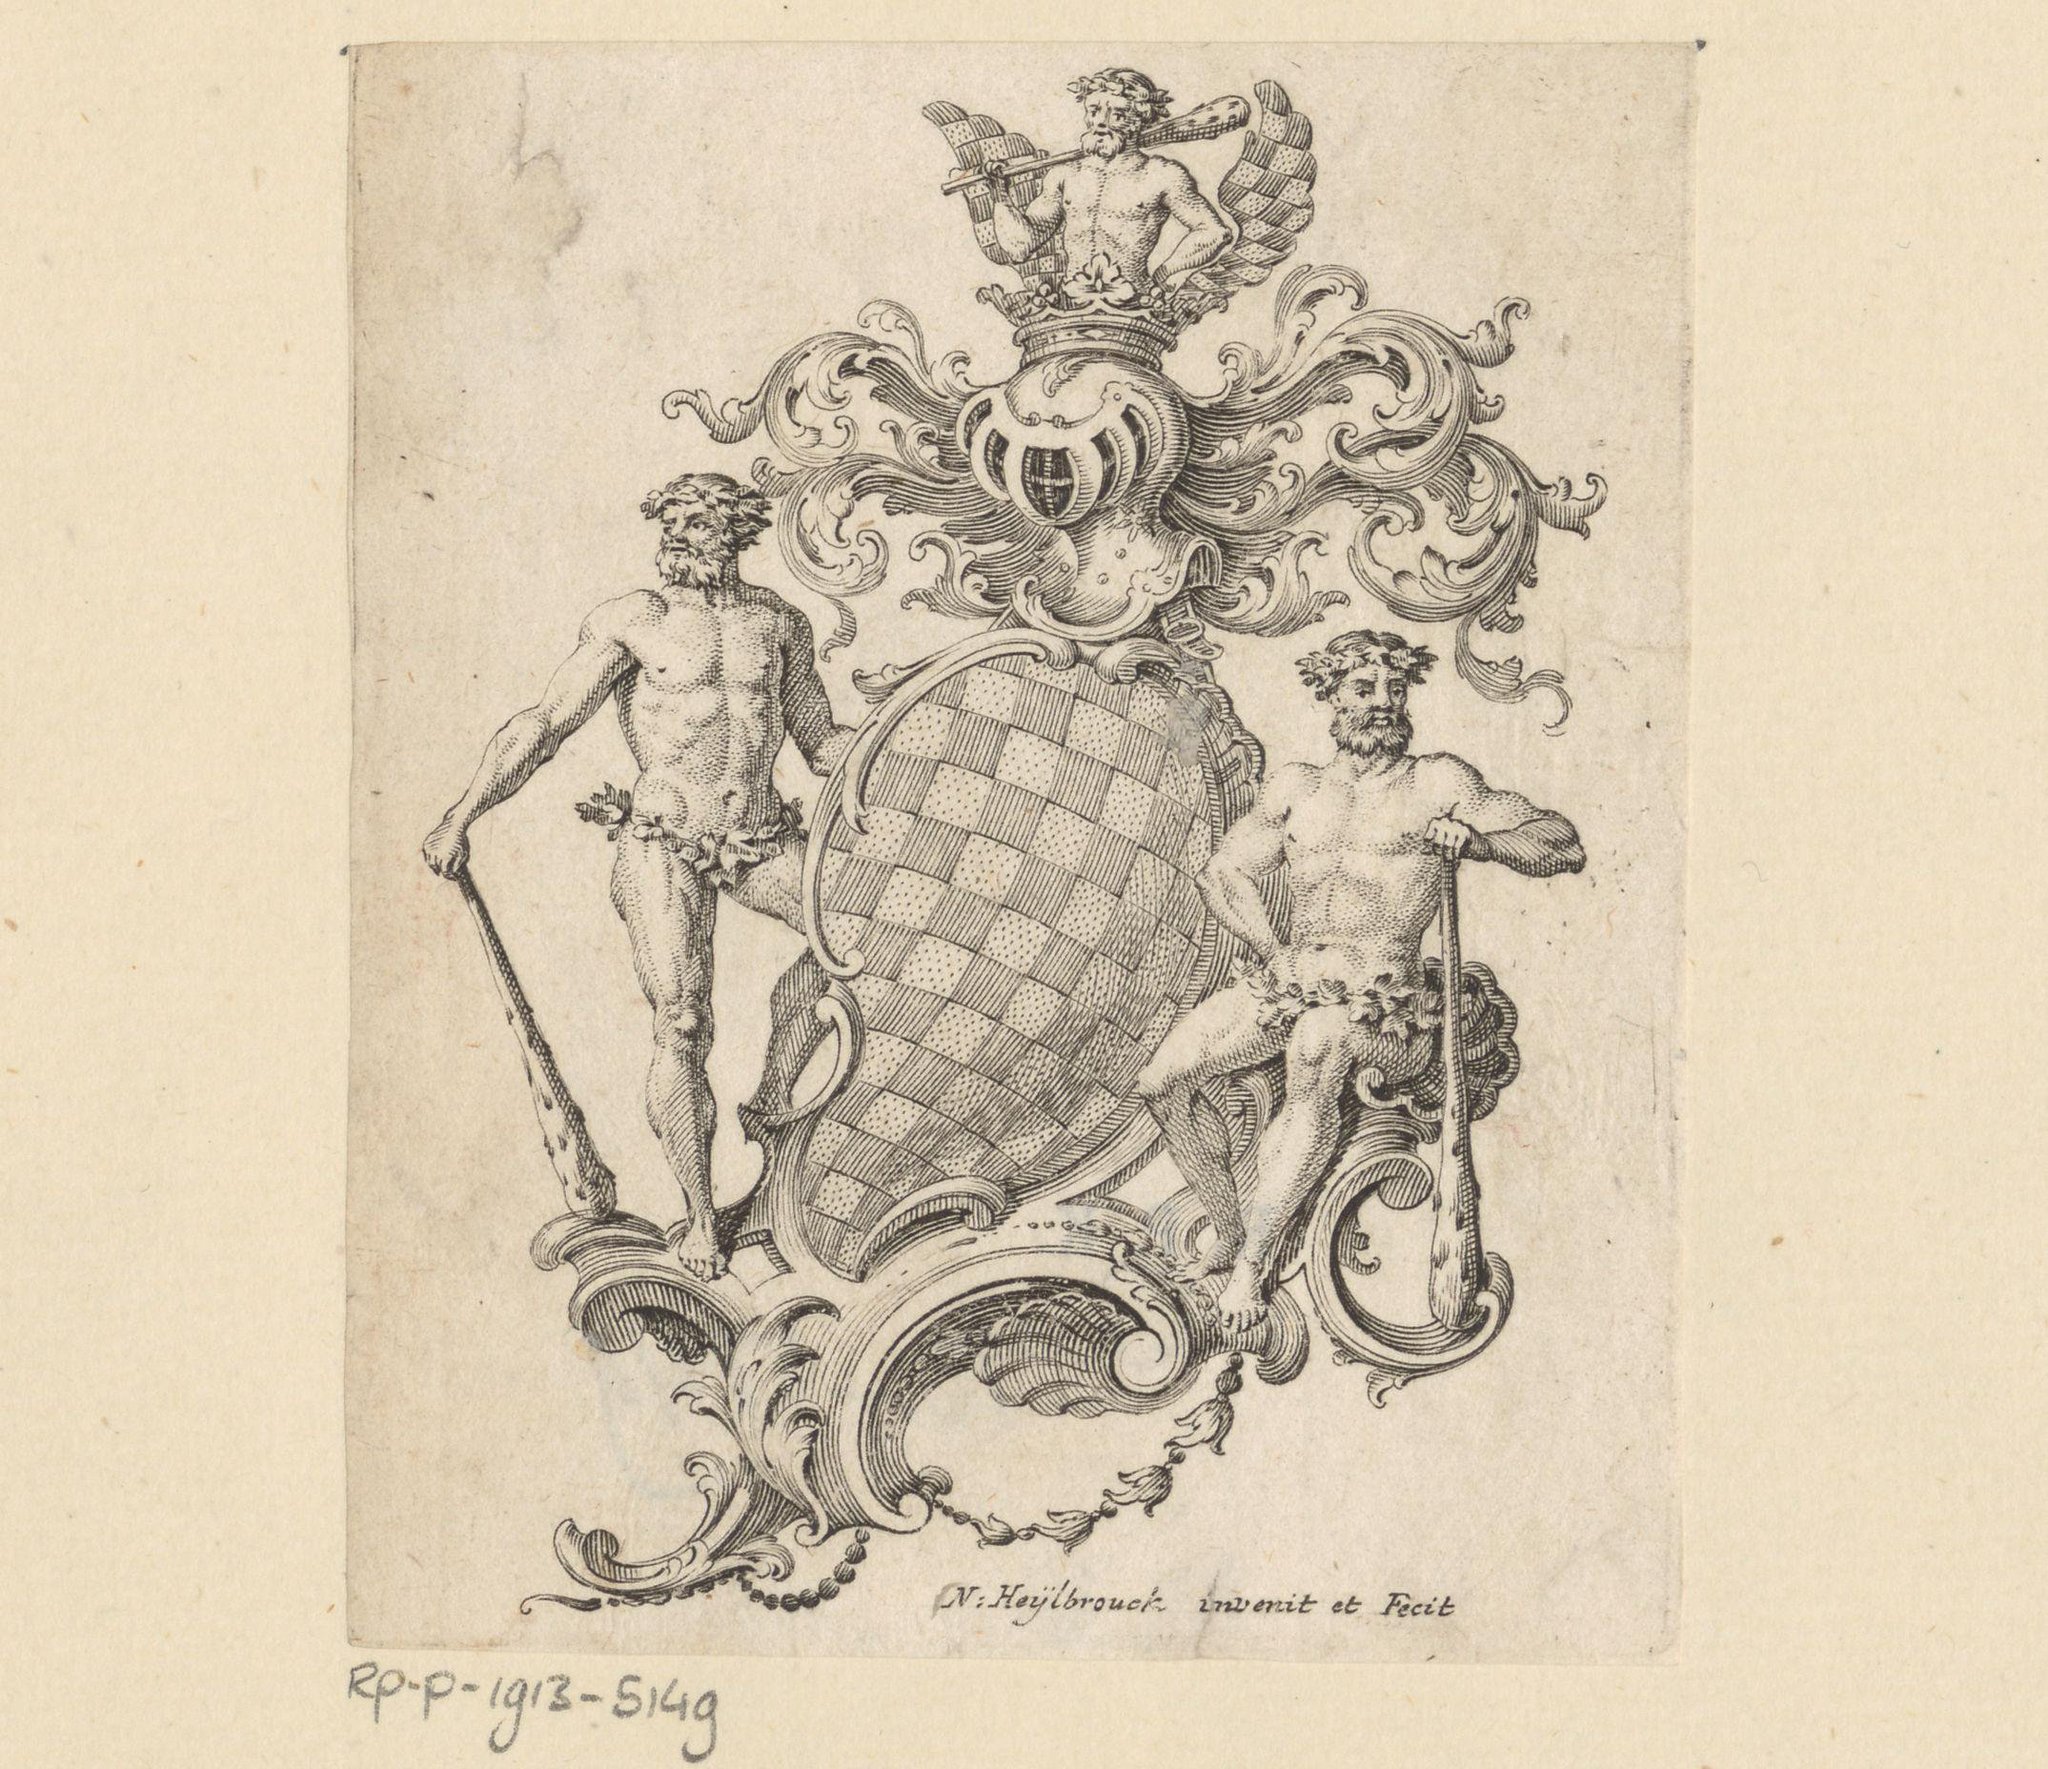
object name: bookplate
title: Ex libris van onbekend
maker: norbert heylbrouck (i)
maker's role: print maker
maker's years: 1675-1762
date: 1750-1762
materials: paper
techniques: engraving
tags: armorial bearing, heraldry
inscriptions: collector's mark: Lugt 2760, collector's mark: Lugt 2233